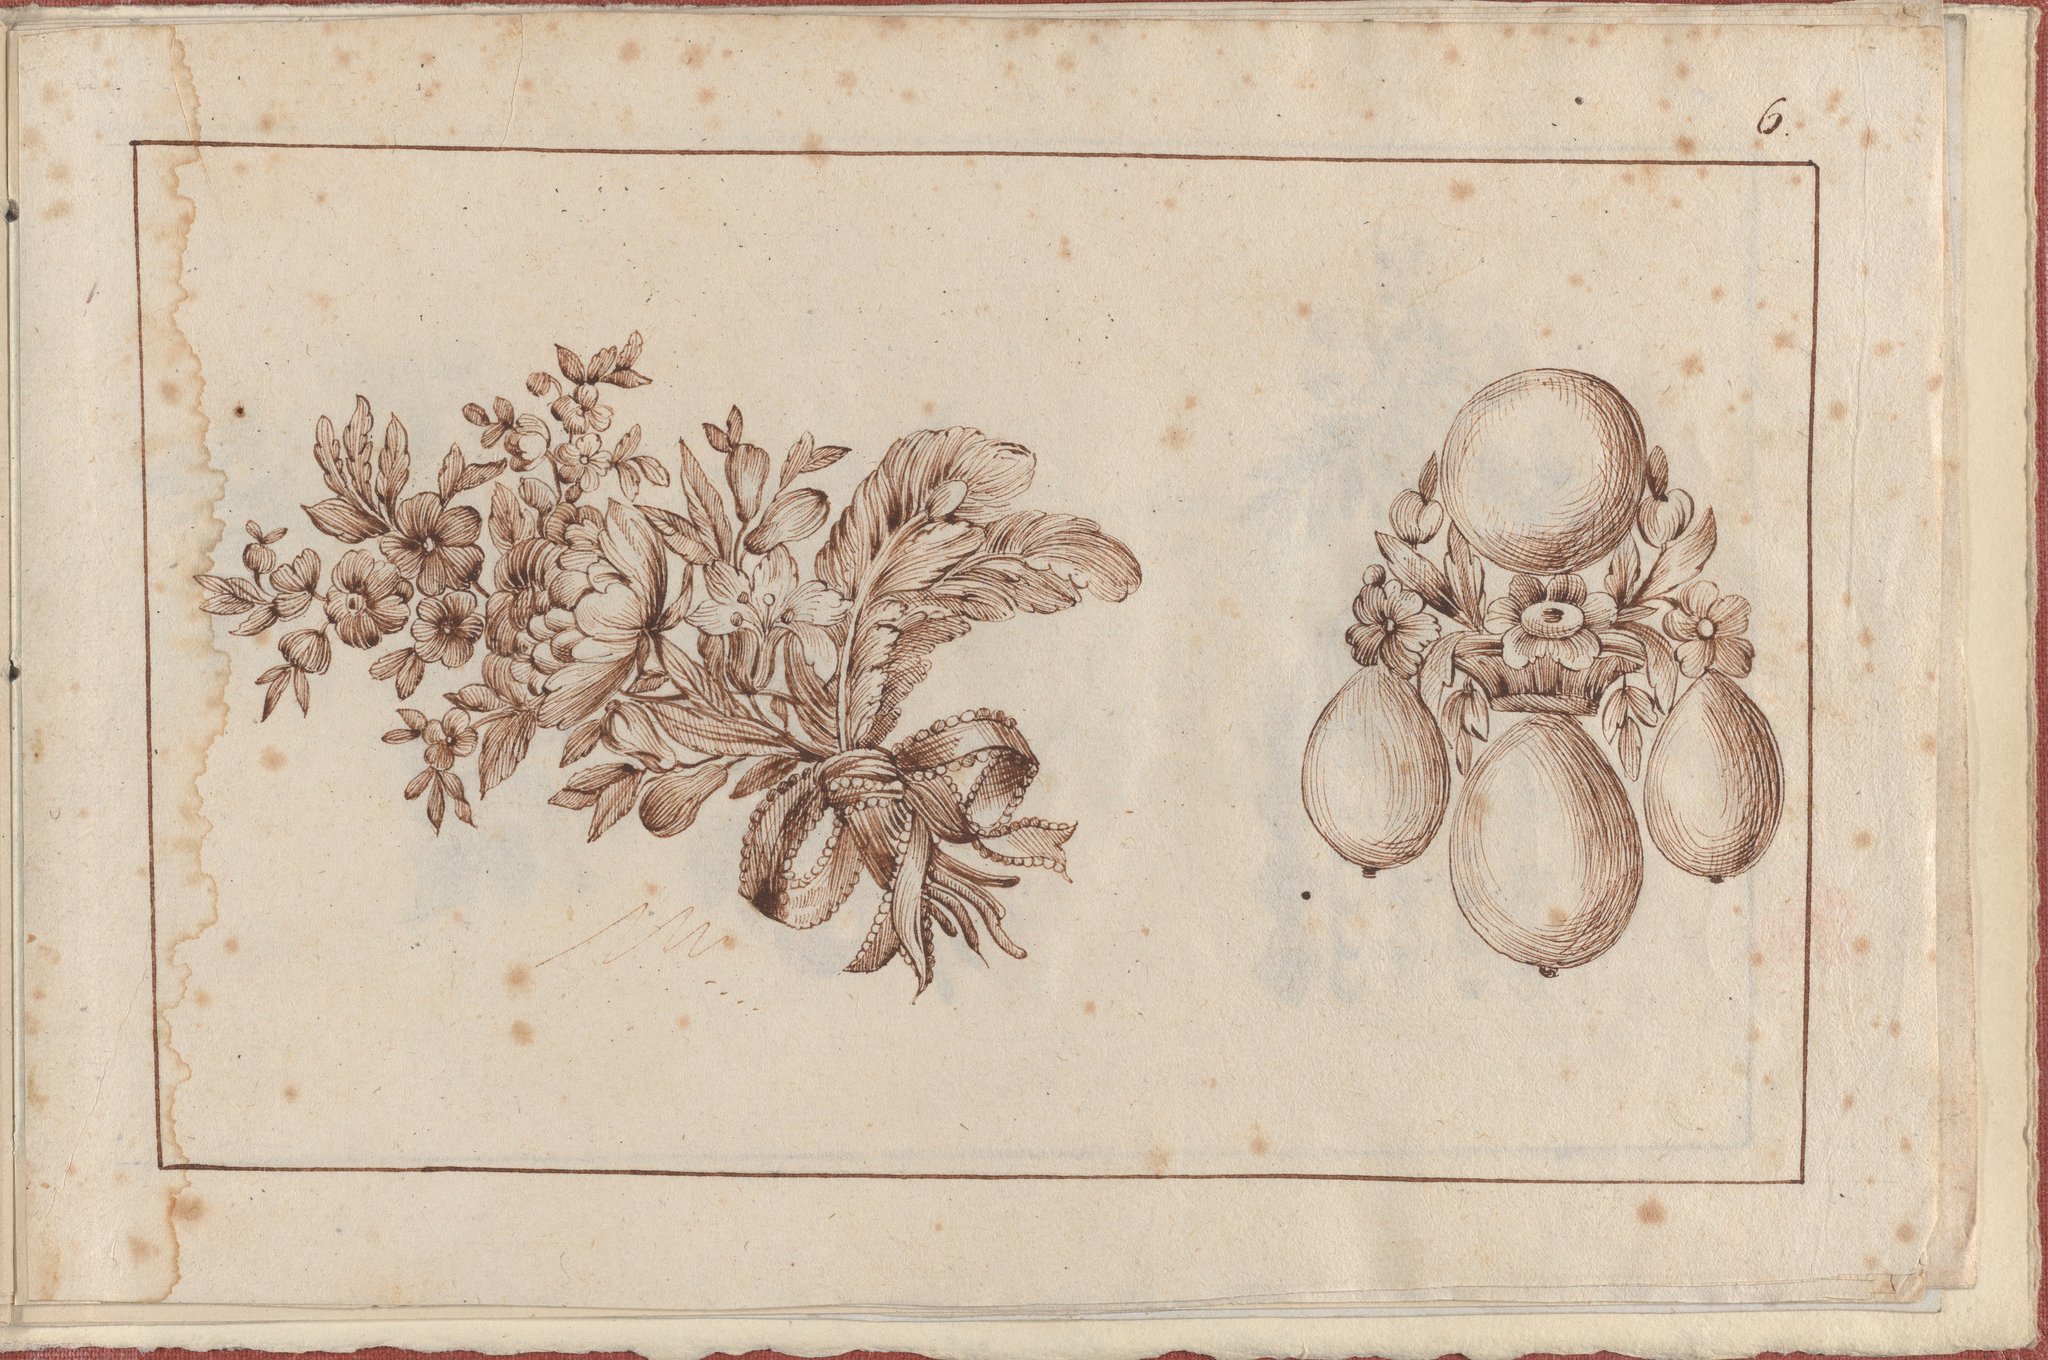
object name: album print ornament architecture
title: Joaillerie: Album of Jewelry Designs, Page 6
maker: anonymous, french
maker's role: artist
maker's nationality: french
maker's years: 1400-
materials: ink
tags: jewelry